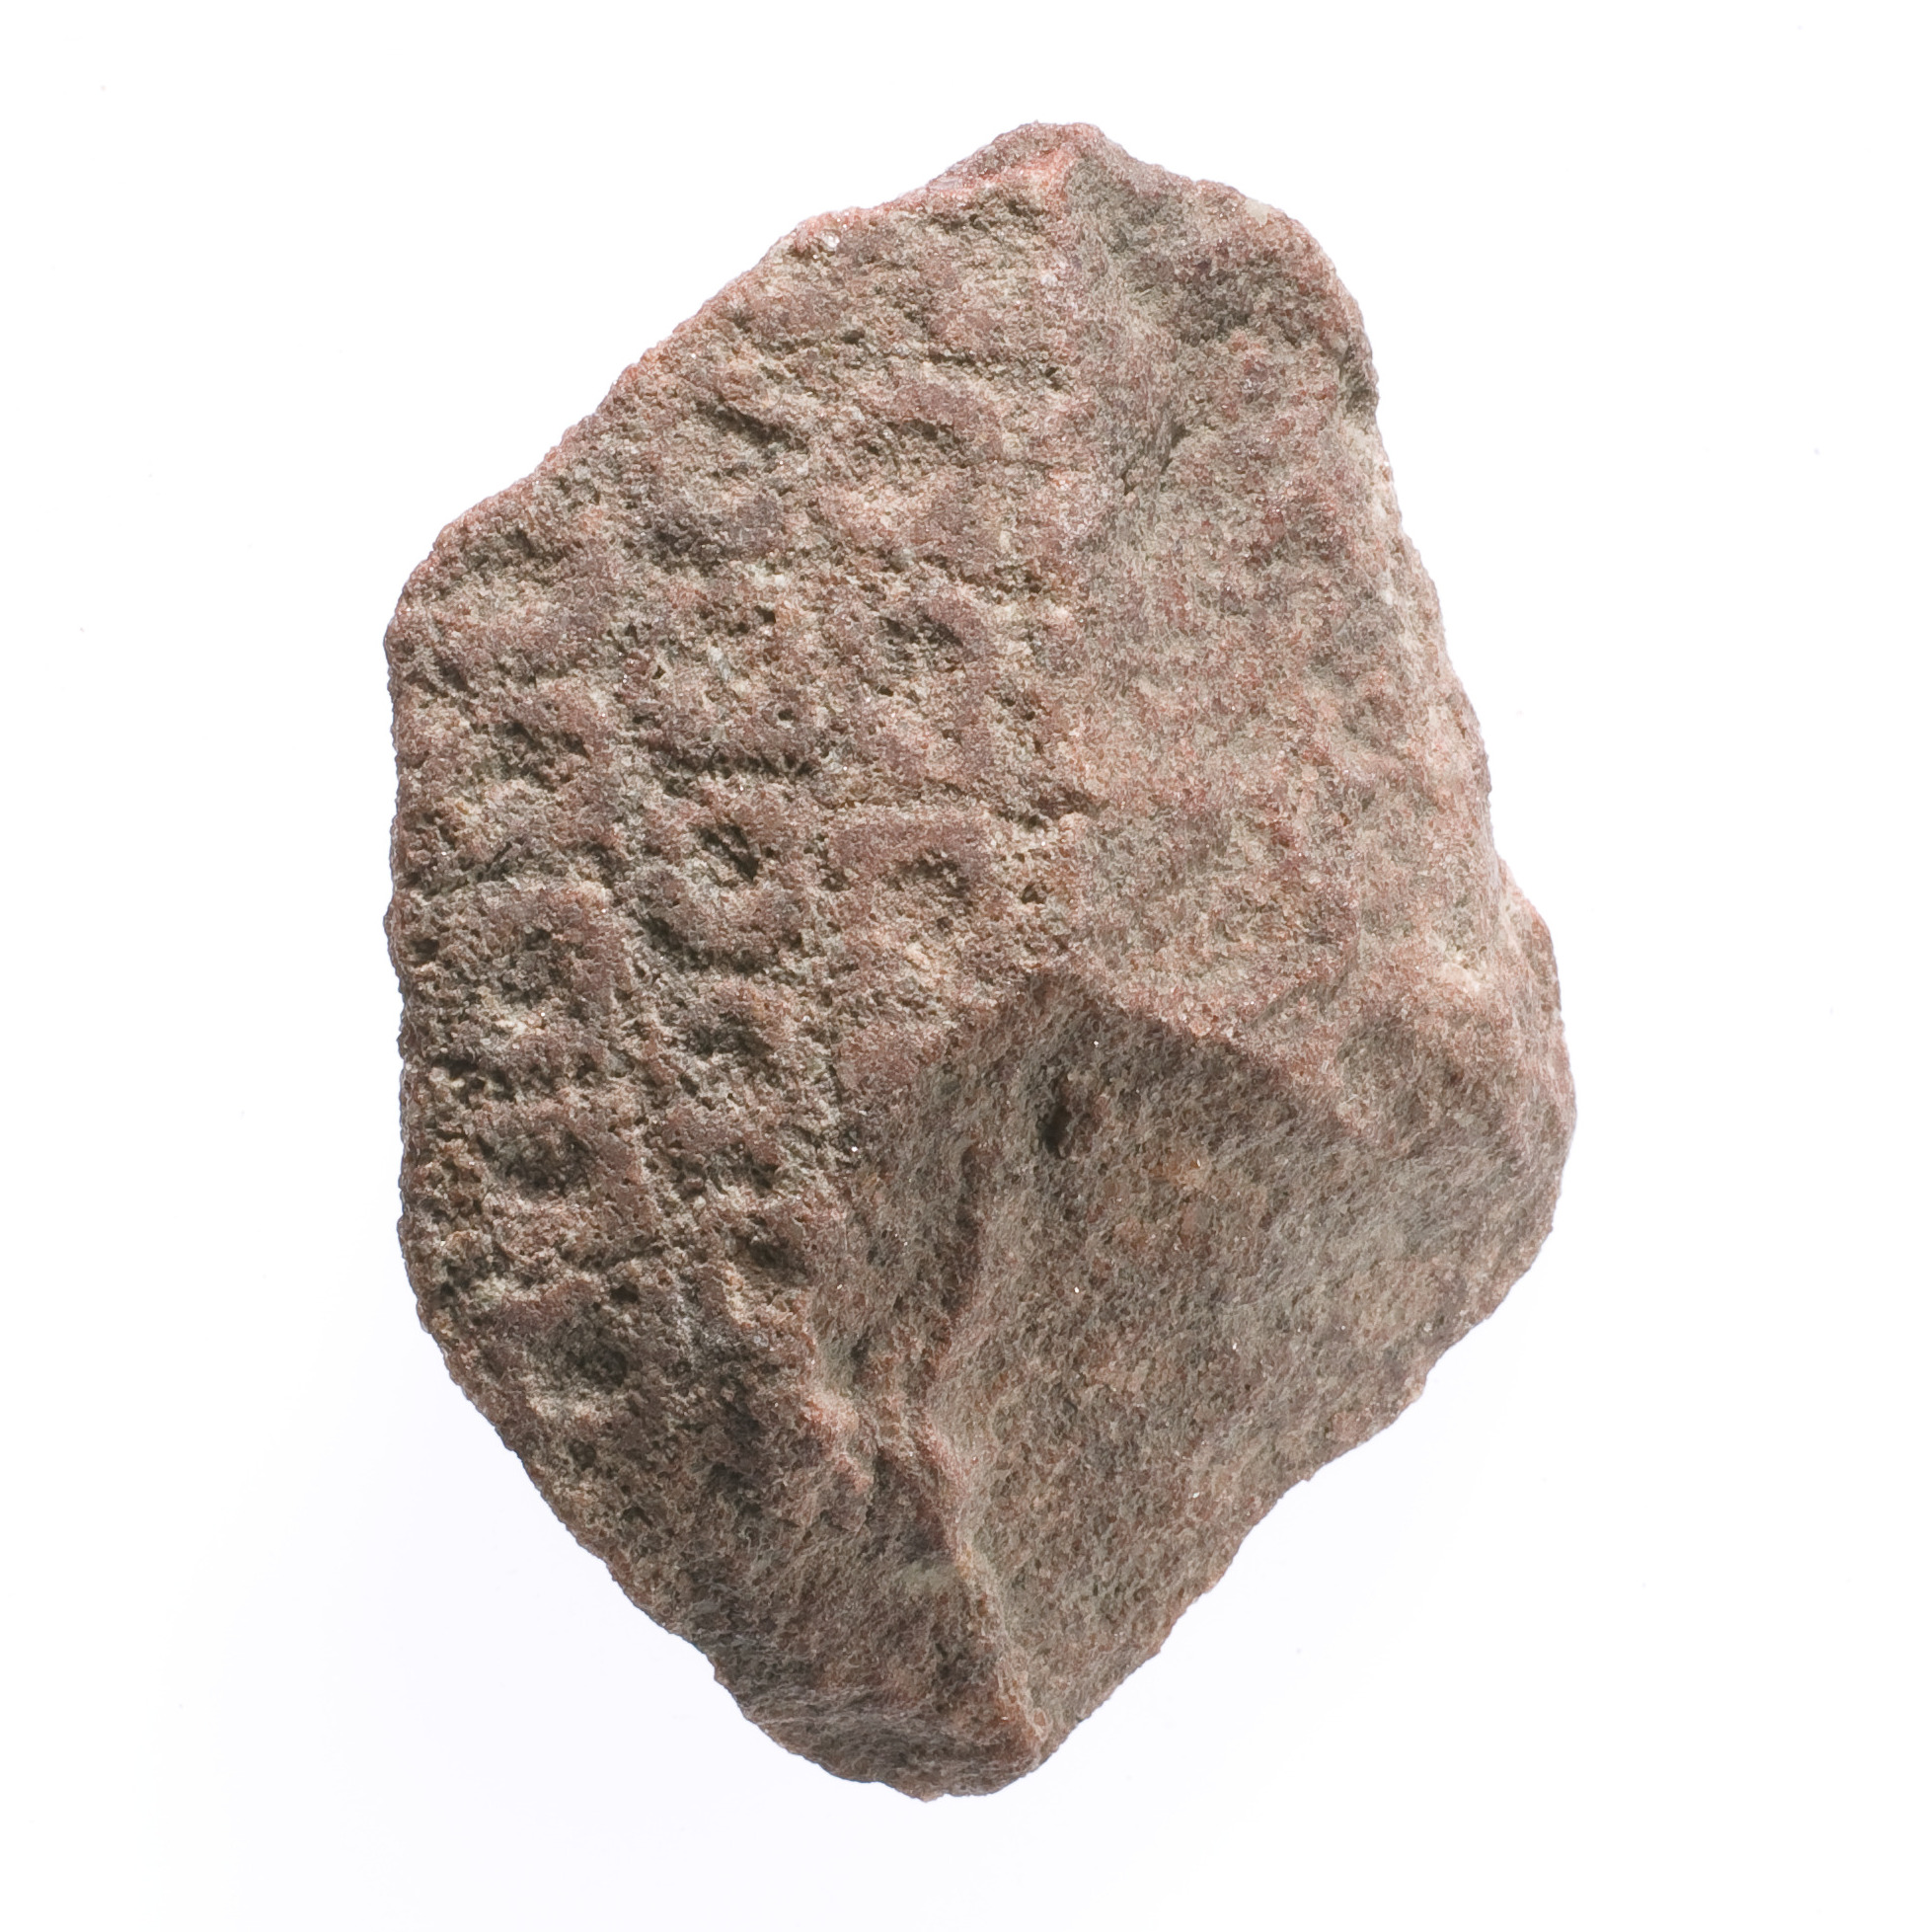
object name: crown with disc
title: Crown with discs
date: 1353-1336 BCE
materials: quartzite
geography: egypt